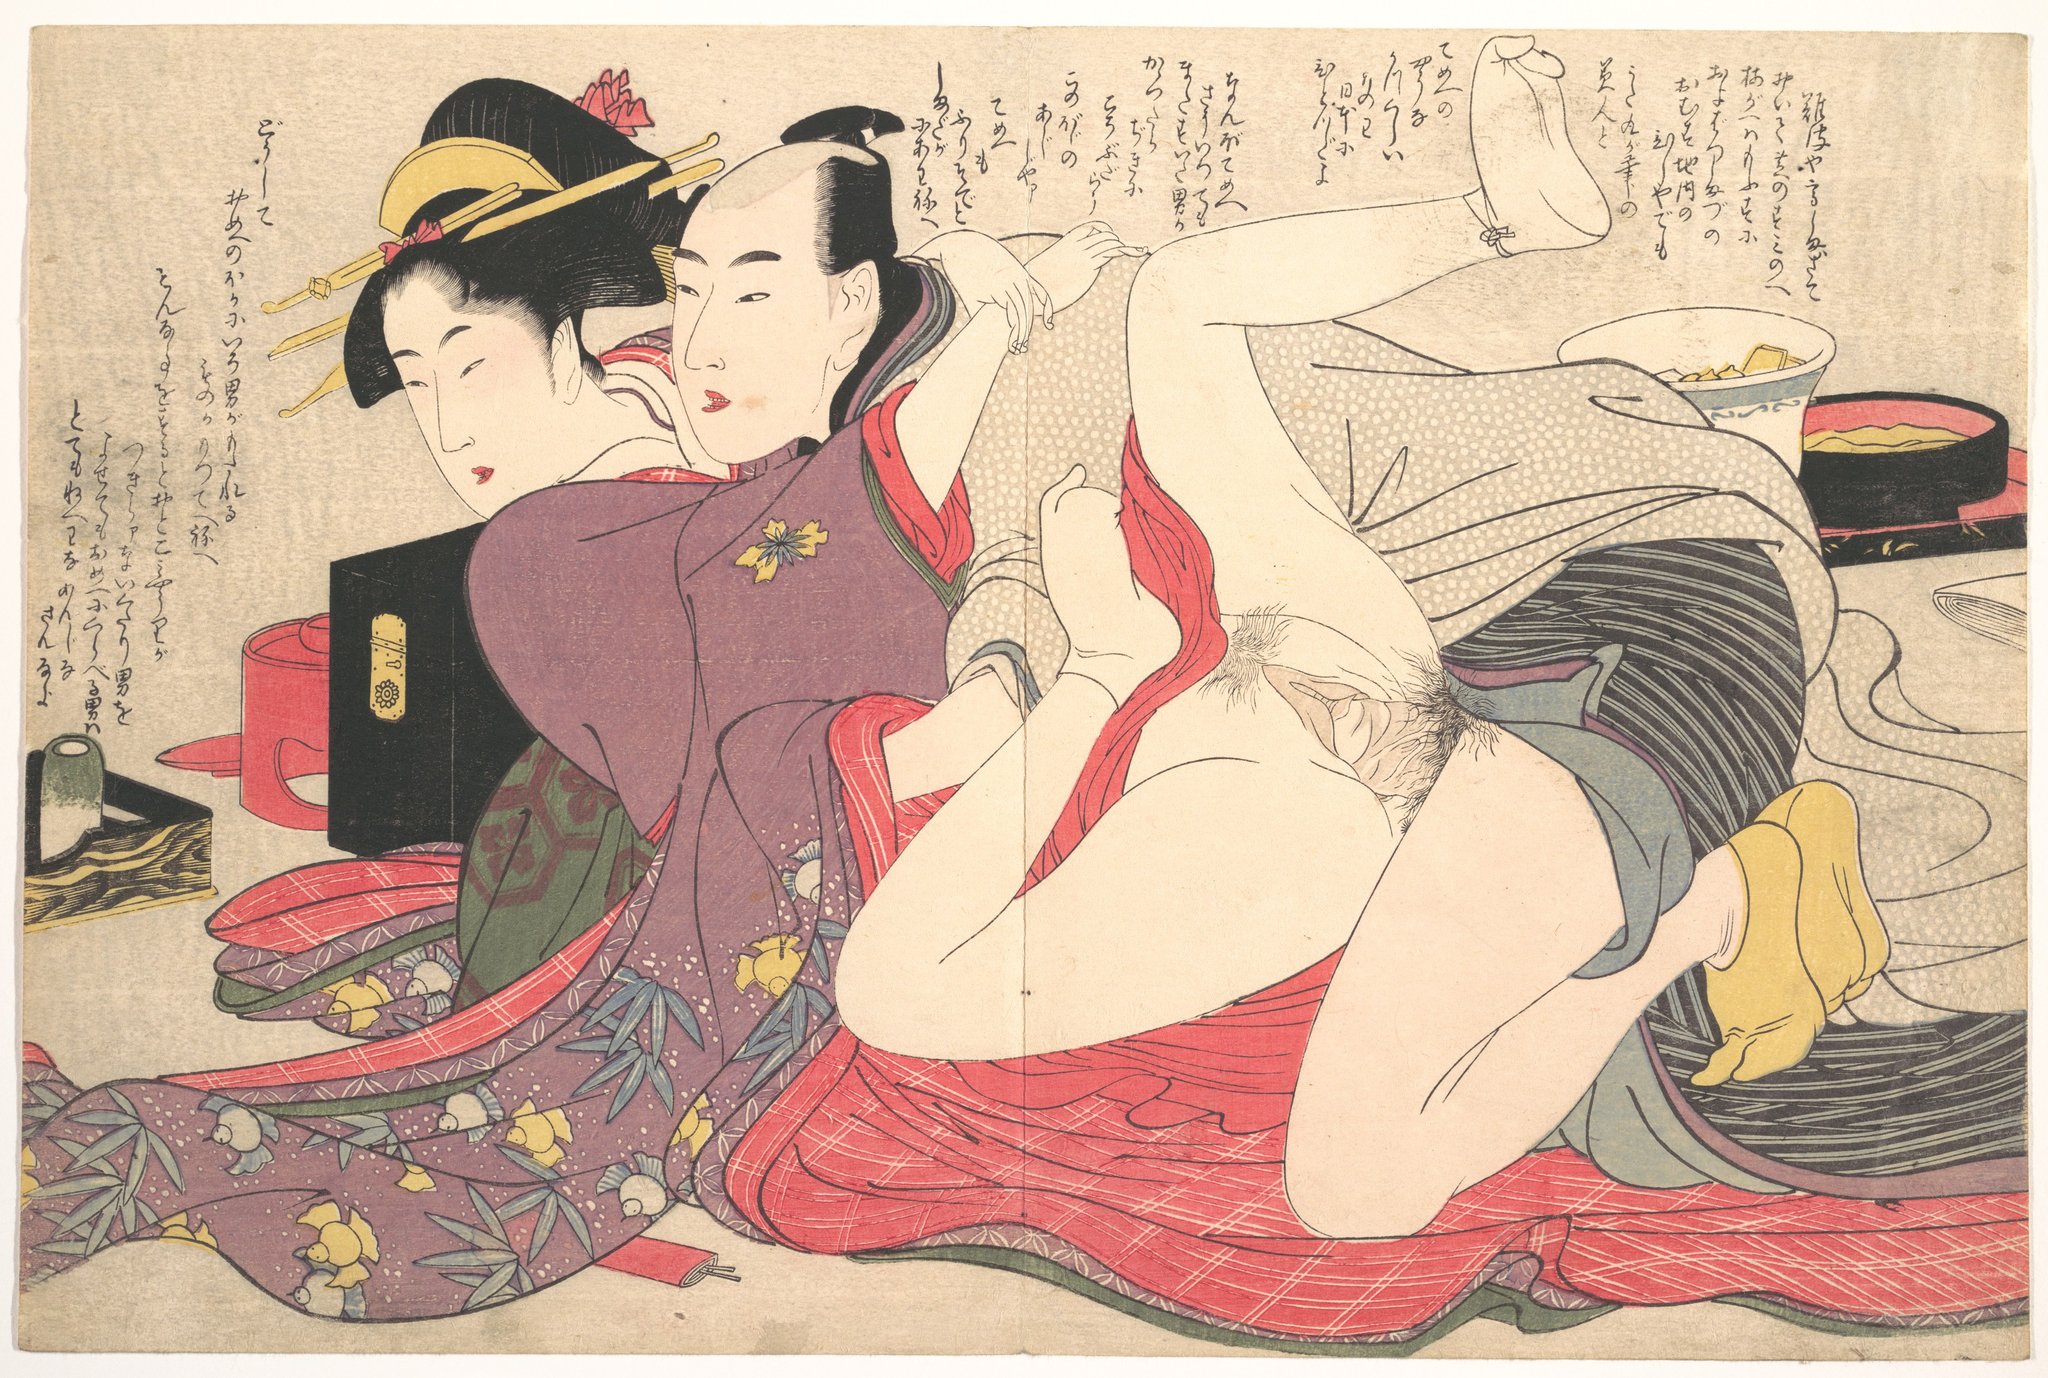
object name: print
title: Erotic Print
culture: japanese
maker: kitagawa utamaro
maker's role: artist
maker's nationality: japanese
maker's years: 1754-1806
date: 1753-1806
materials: ink, paper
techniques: woodblock print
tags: men,women,female nudes